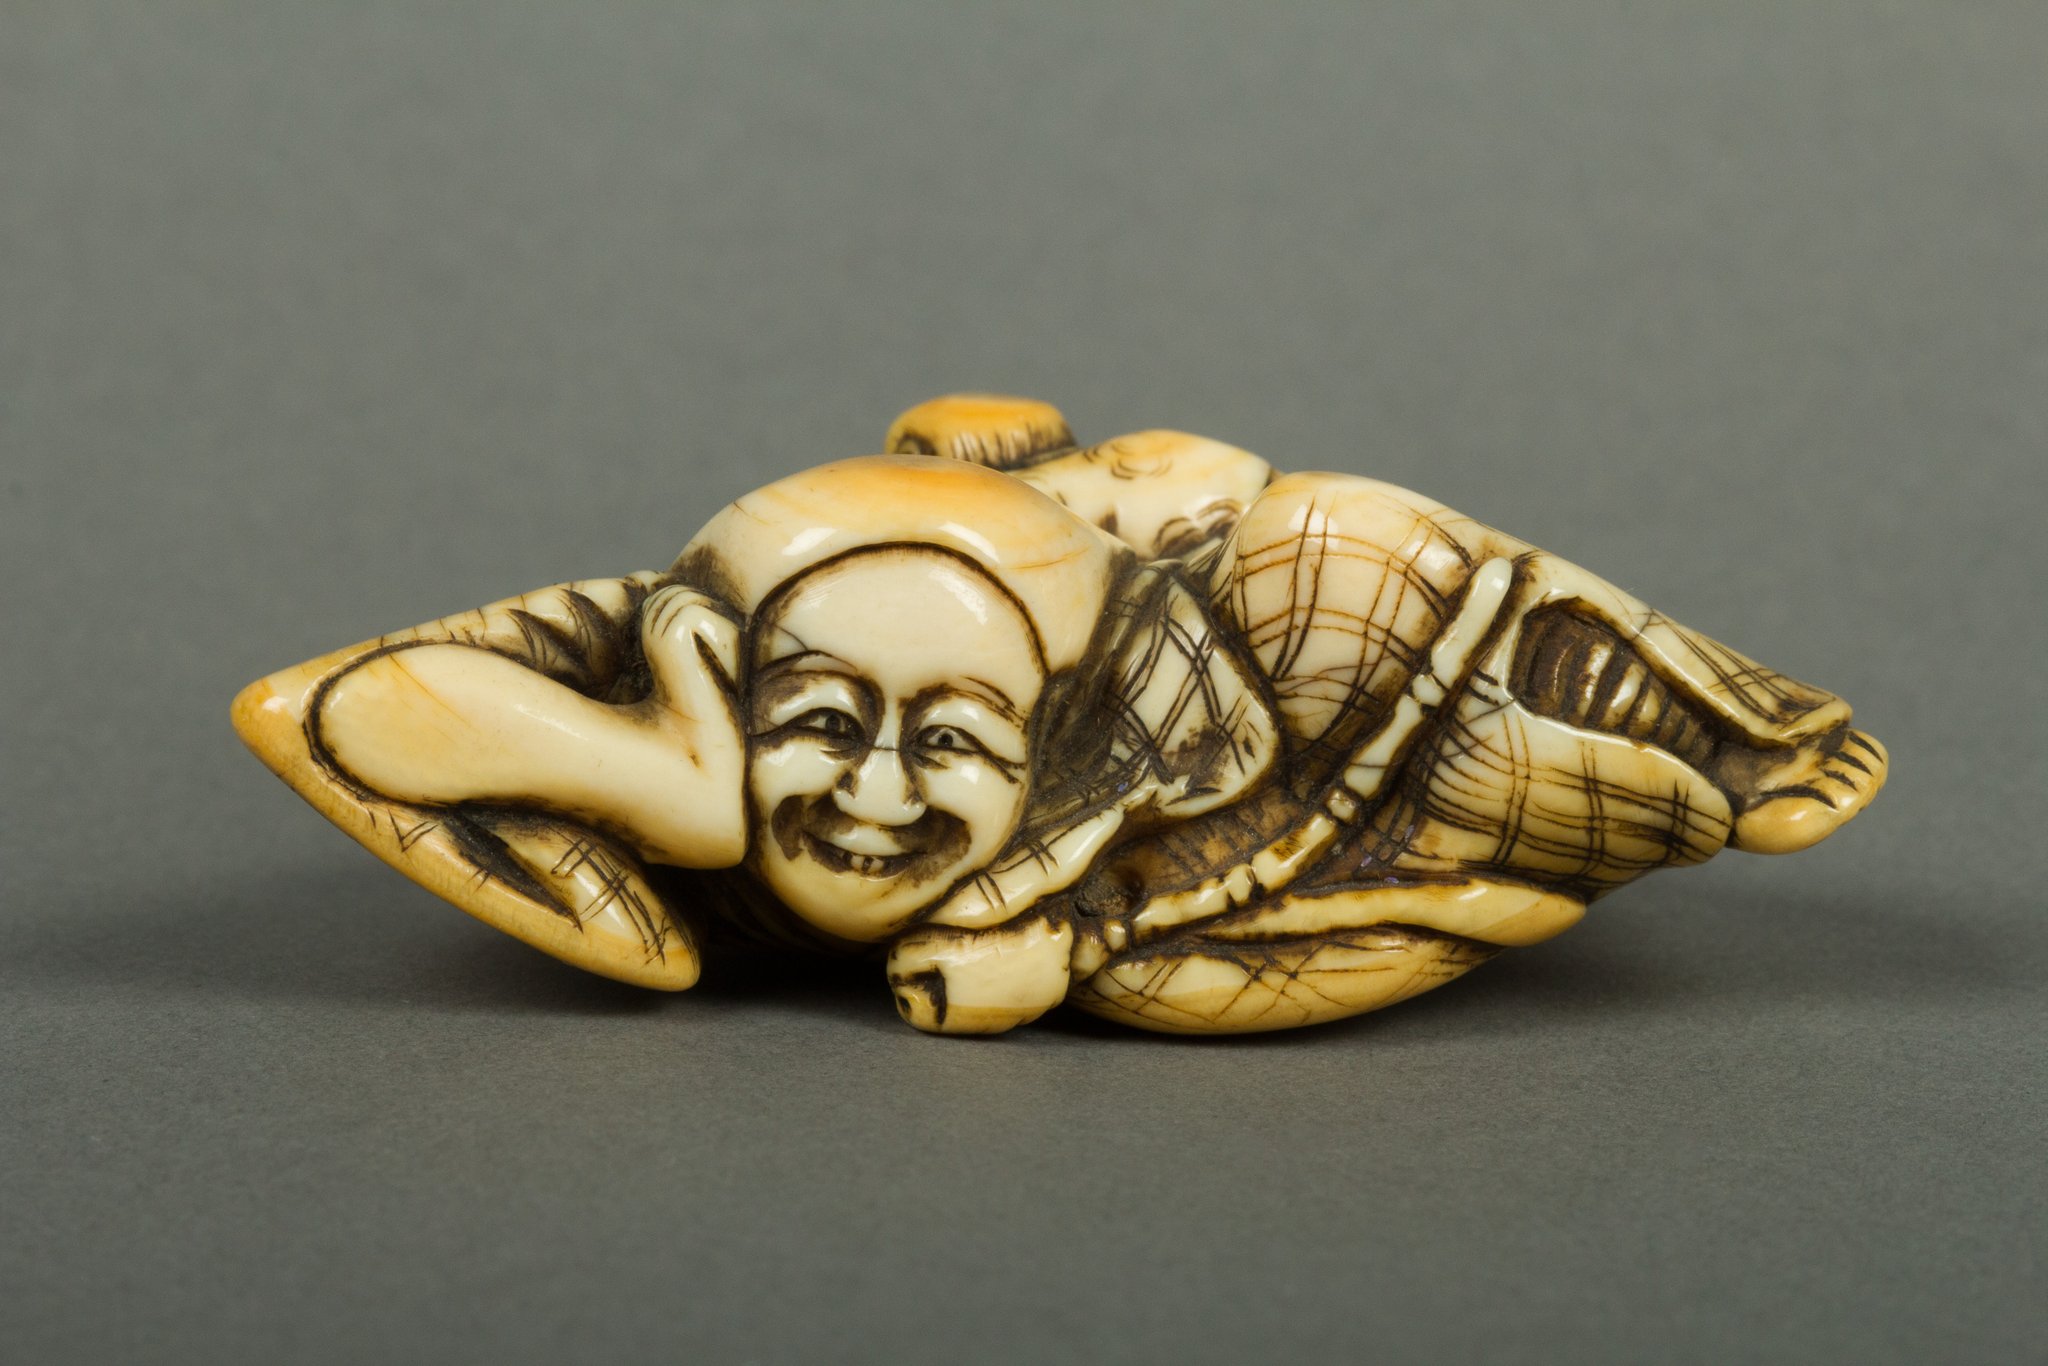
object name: netsuke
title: Netsuke of Woman and Monkey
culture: japanese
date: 1801-1900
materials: ivory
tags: women